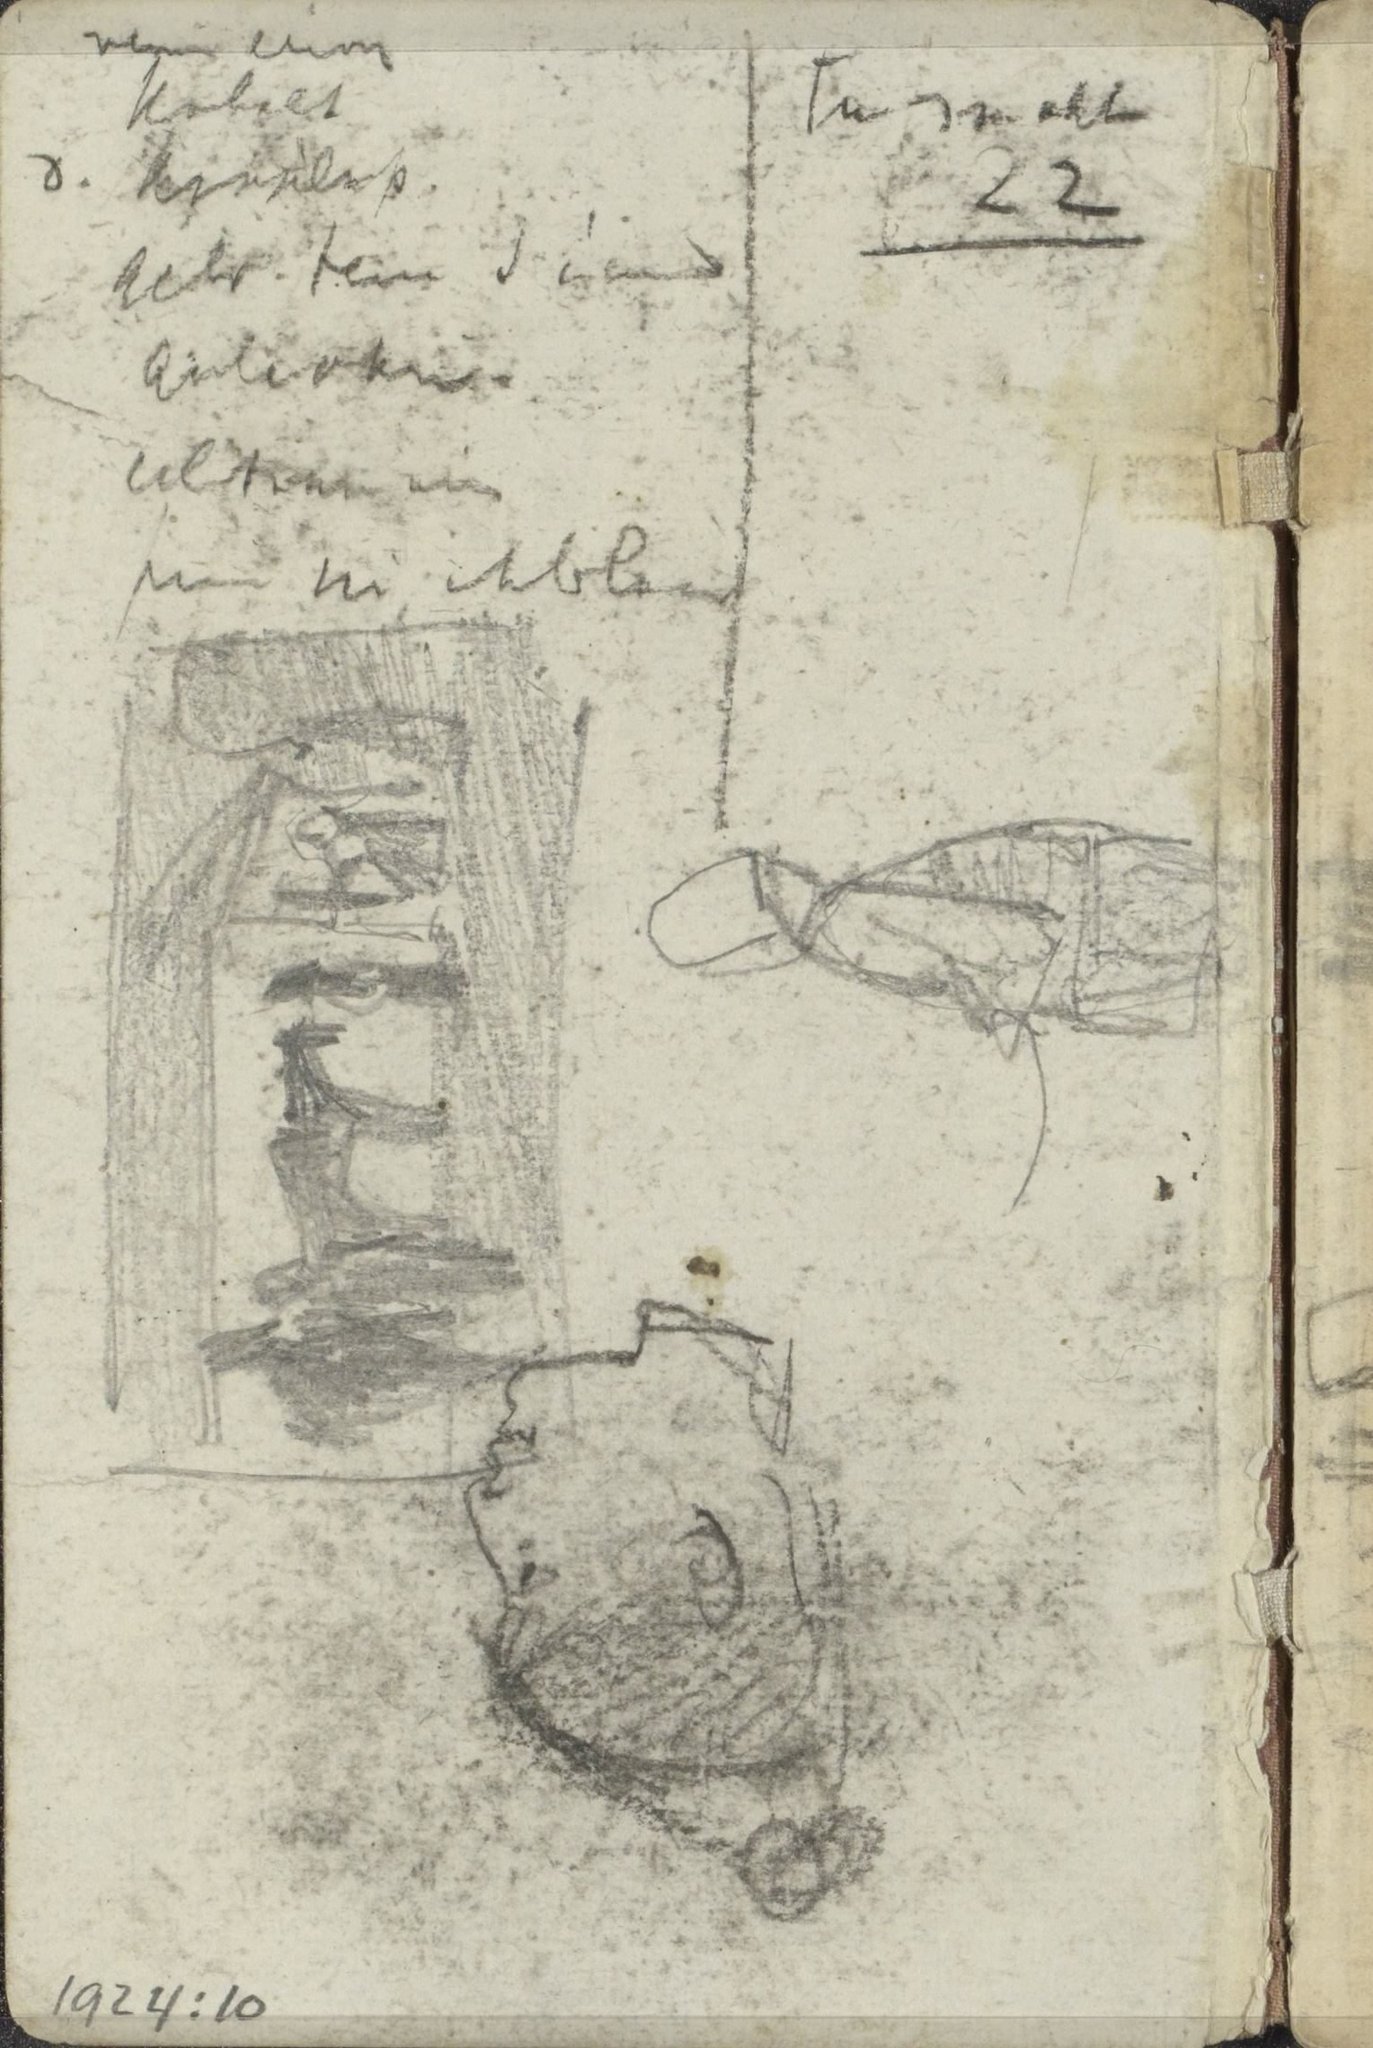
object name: endleaf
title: Compositiestudie met paarden en figuurstudies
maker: george hendrik breitner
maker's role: draughtsman, painter, print maker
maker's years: 1857-1923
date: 1880-1882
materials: chalk, paper, pencil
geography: the hague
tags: adult woman, adult man, horse, head (human) - aa - female human figure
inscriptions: annotation: ‘[...]’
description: Pagina 1, voorste schutblad, uit een schetsboek met 19 bladen.